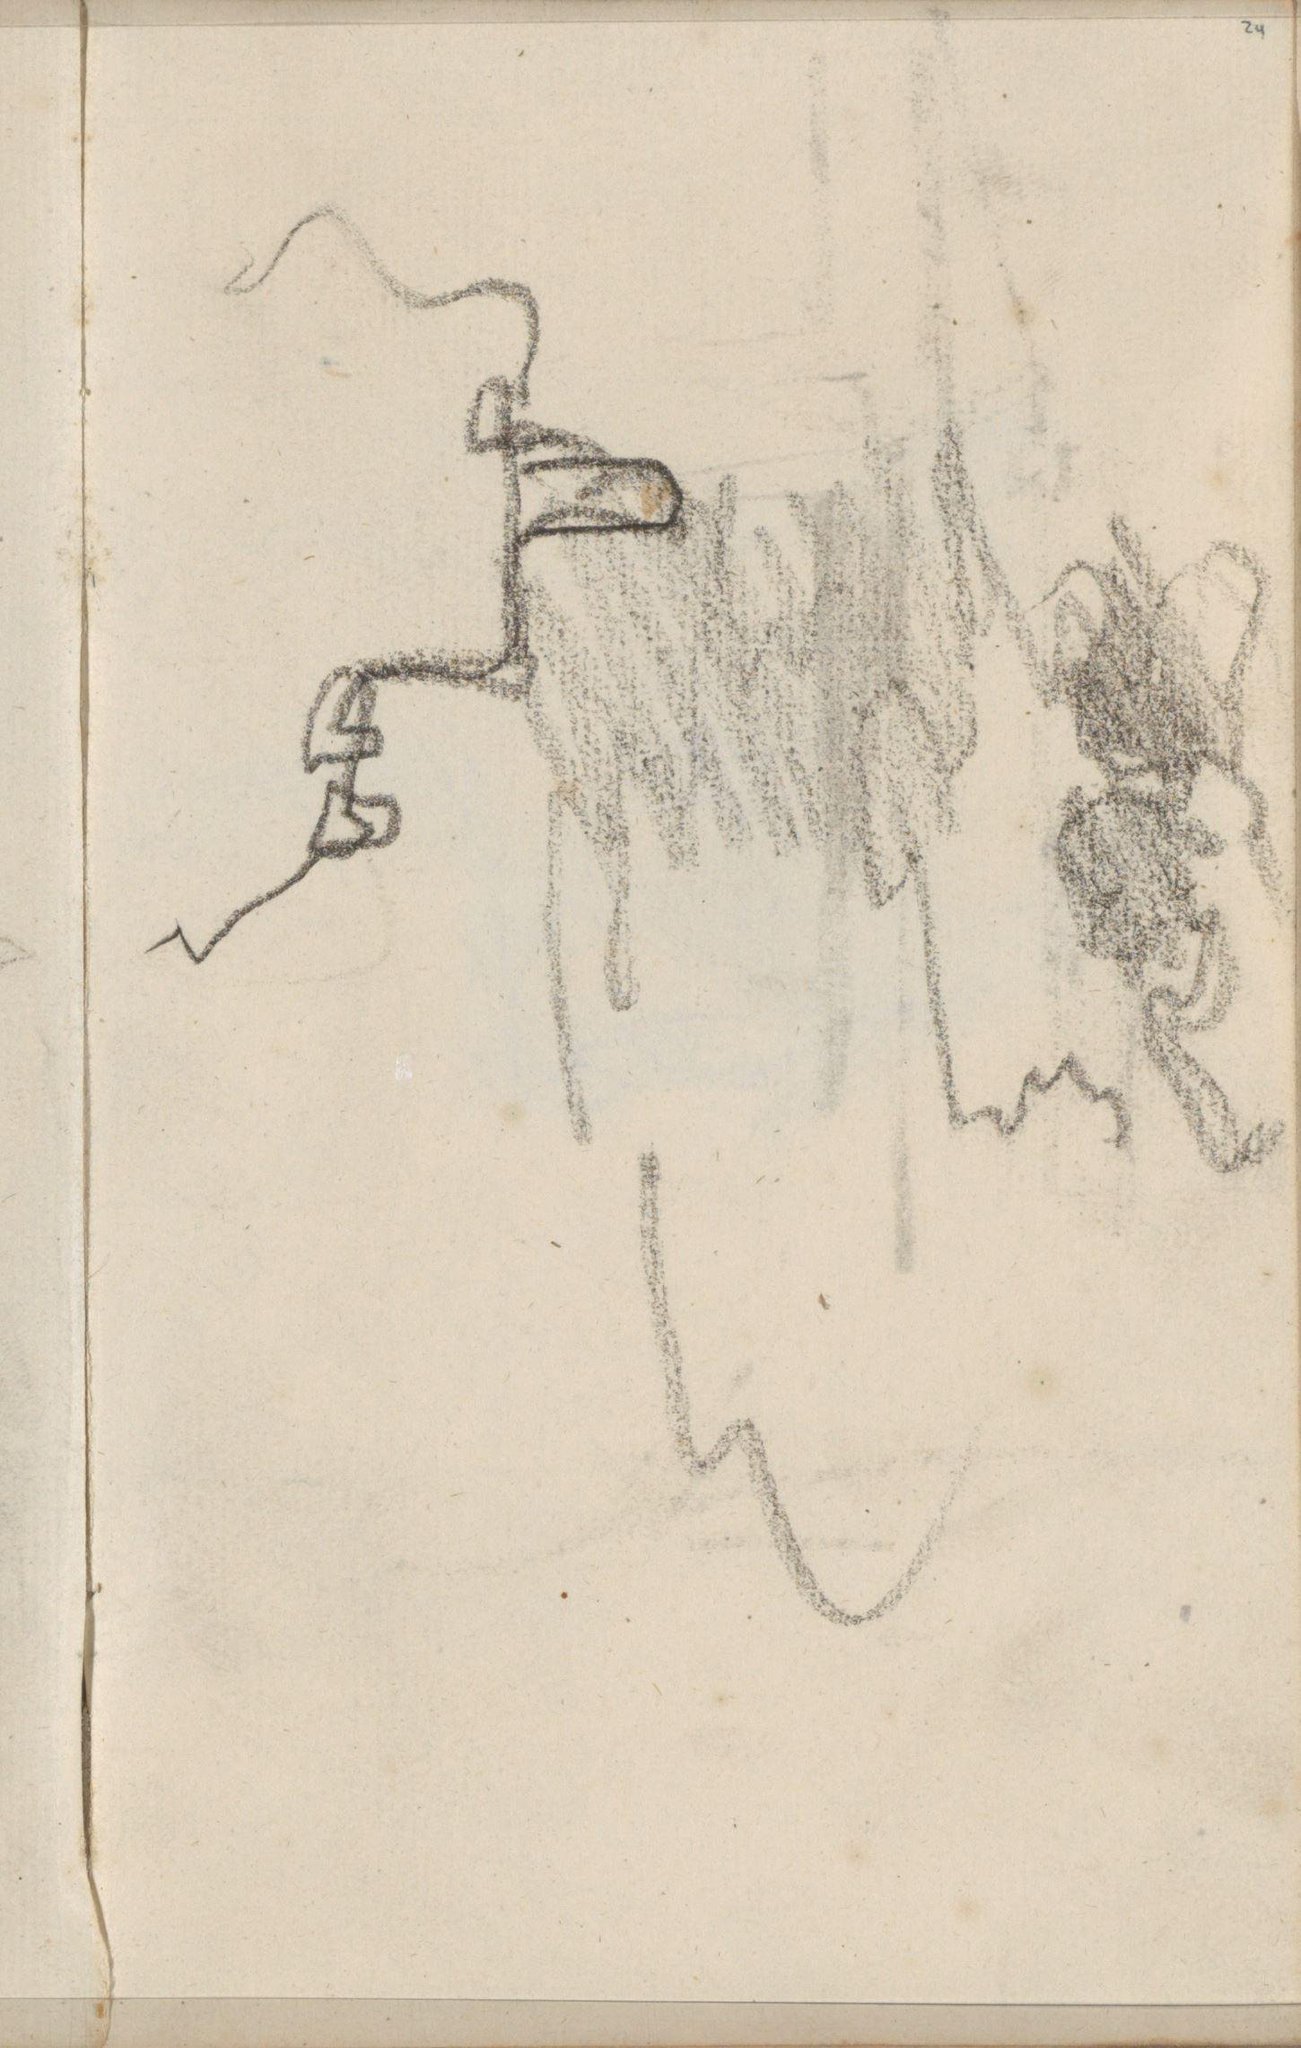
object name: sketchbook leaf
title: Studie, mogelijk van daken met een wolkenlucht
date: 1880-1882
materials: chalk, paper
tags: roof (of house or building), clouds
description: Pagina 24 uit een schetsboek met 31 bladen.